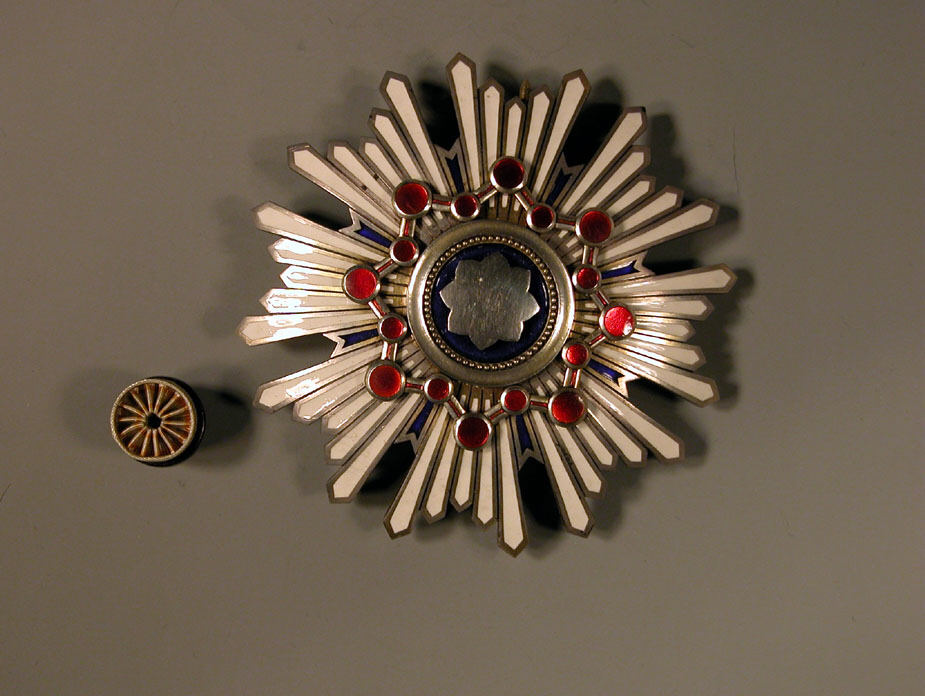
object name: medal and button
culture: japanese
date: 1867-1900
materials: metal